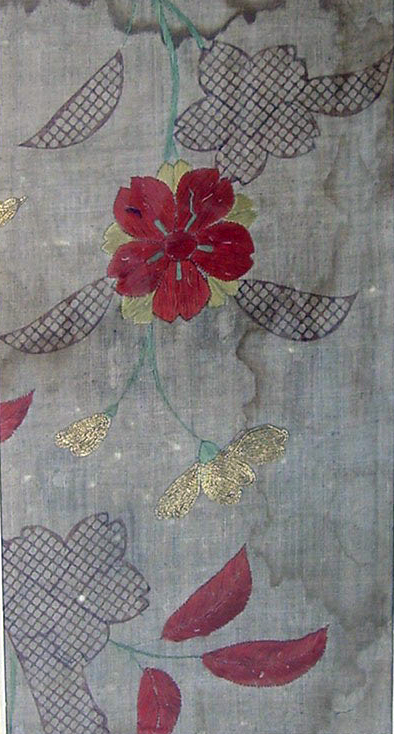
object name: piece from a summer kosode katabira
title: Piece from a Summer Kosode (katabira) with Cherry Blossoms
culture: japanese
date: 1615-1868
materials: fiber, metal thread, silk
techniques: dyeing, embroidery, weave, resist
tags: flowers,leaves